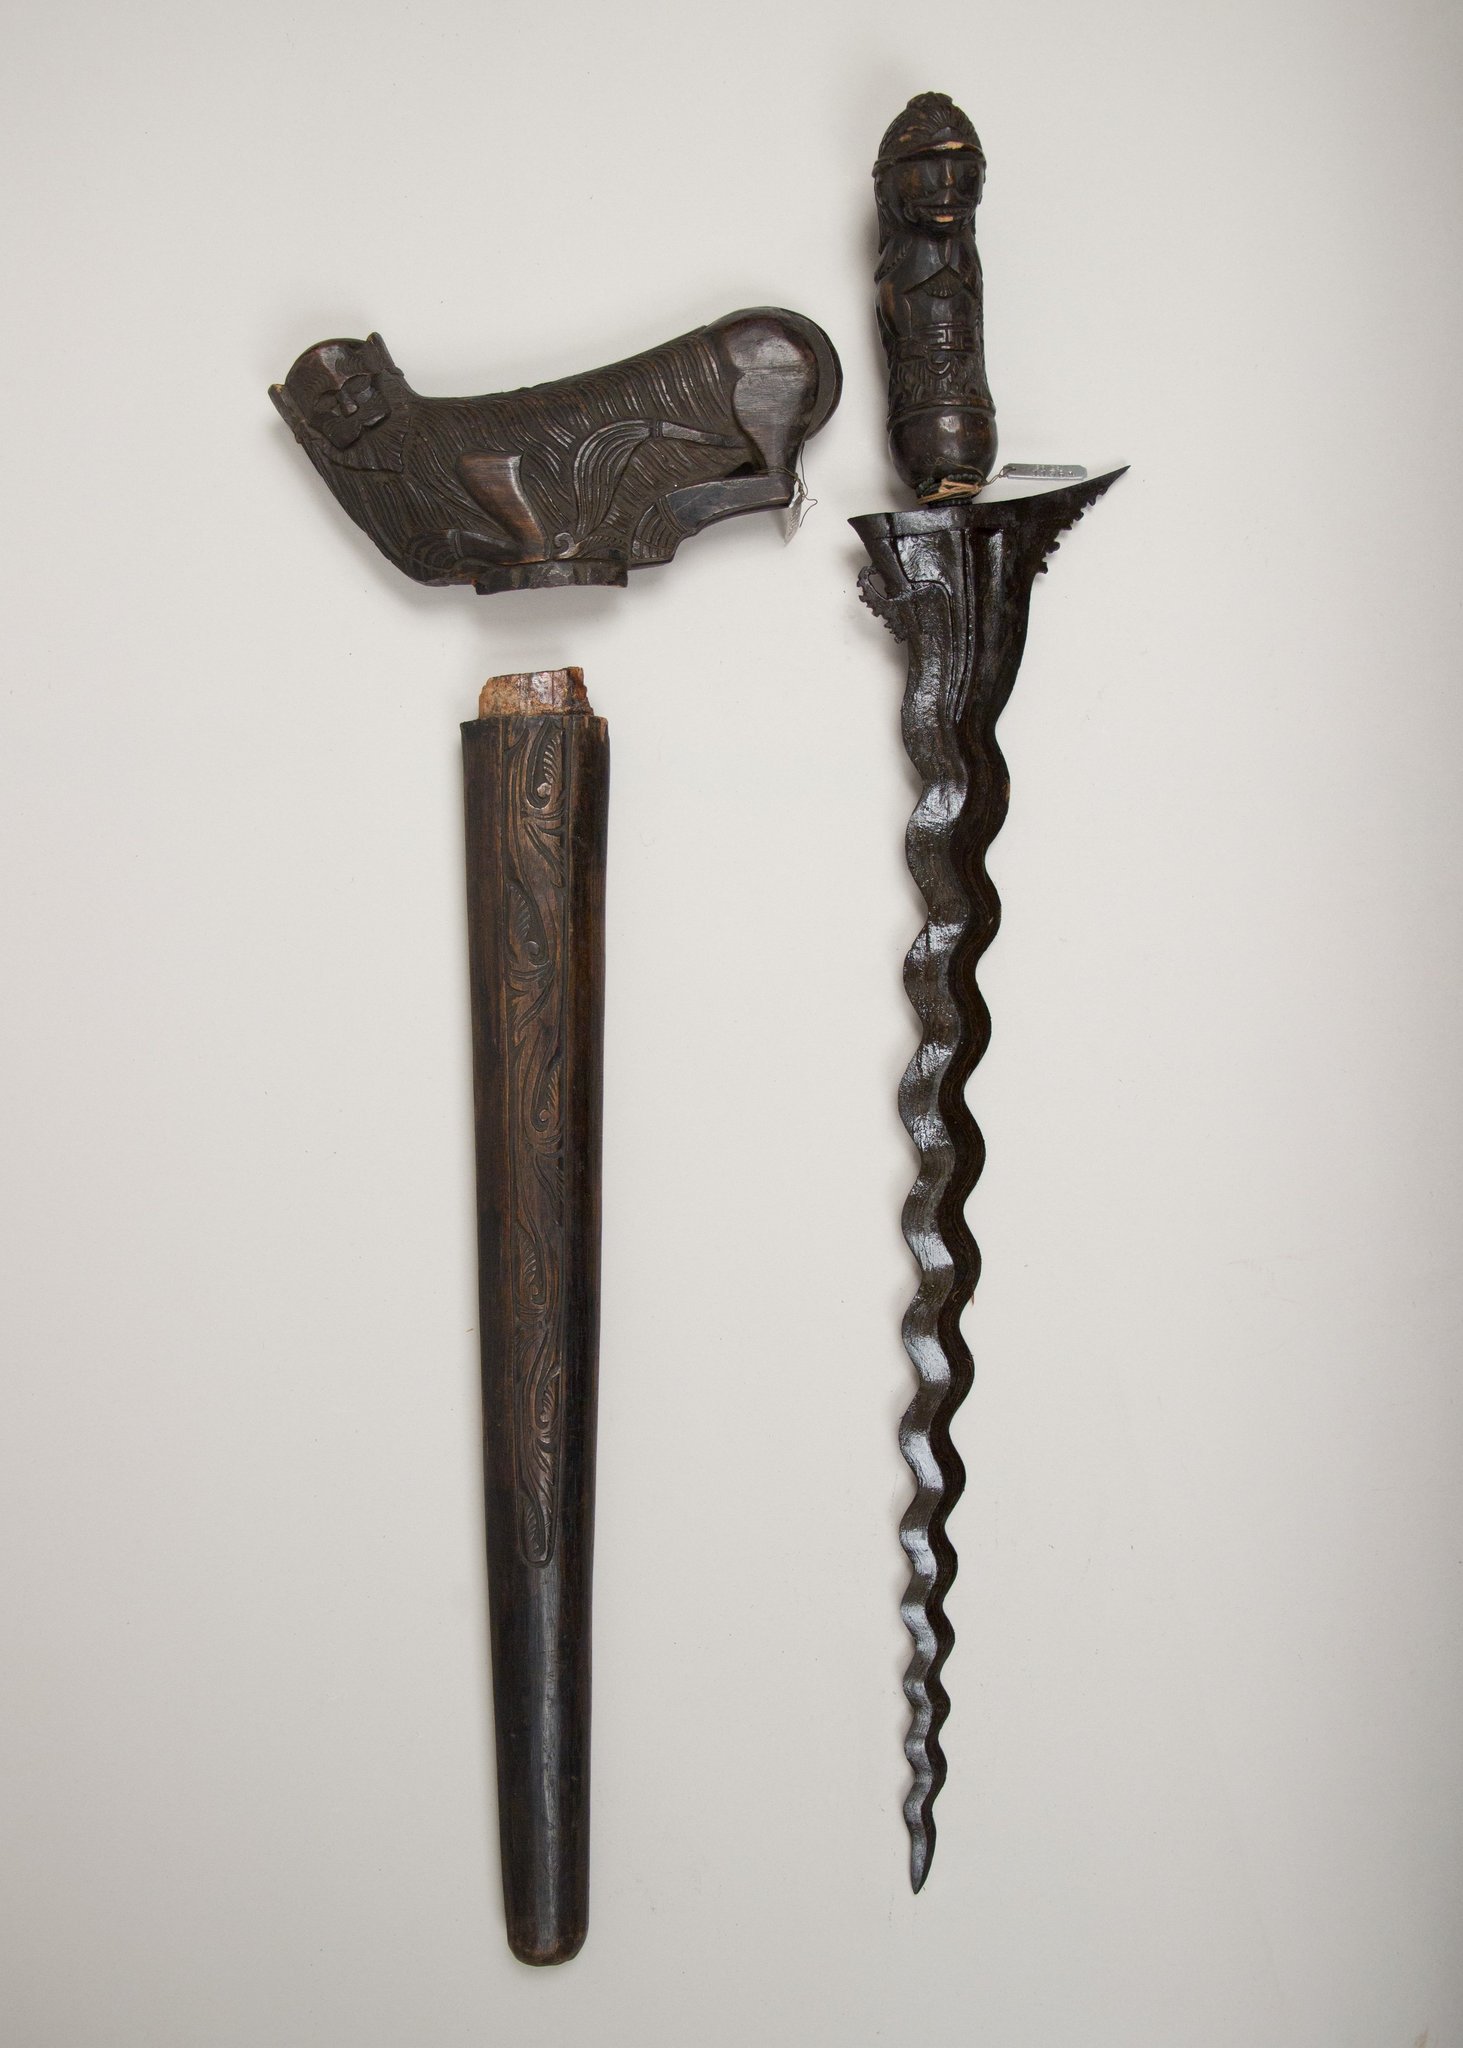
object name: kris with sheath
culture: madurese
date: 1501-1900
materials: wood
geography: indonesia